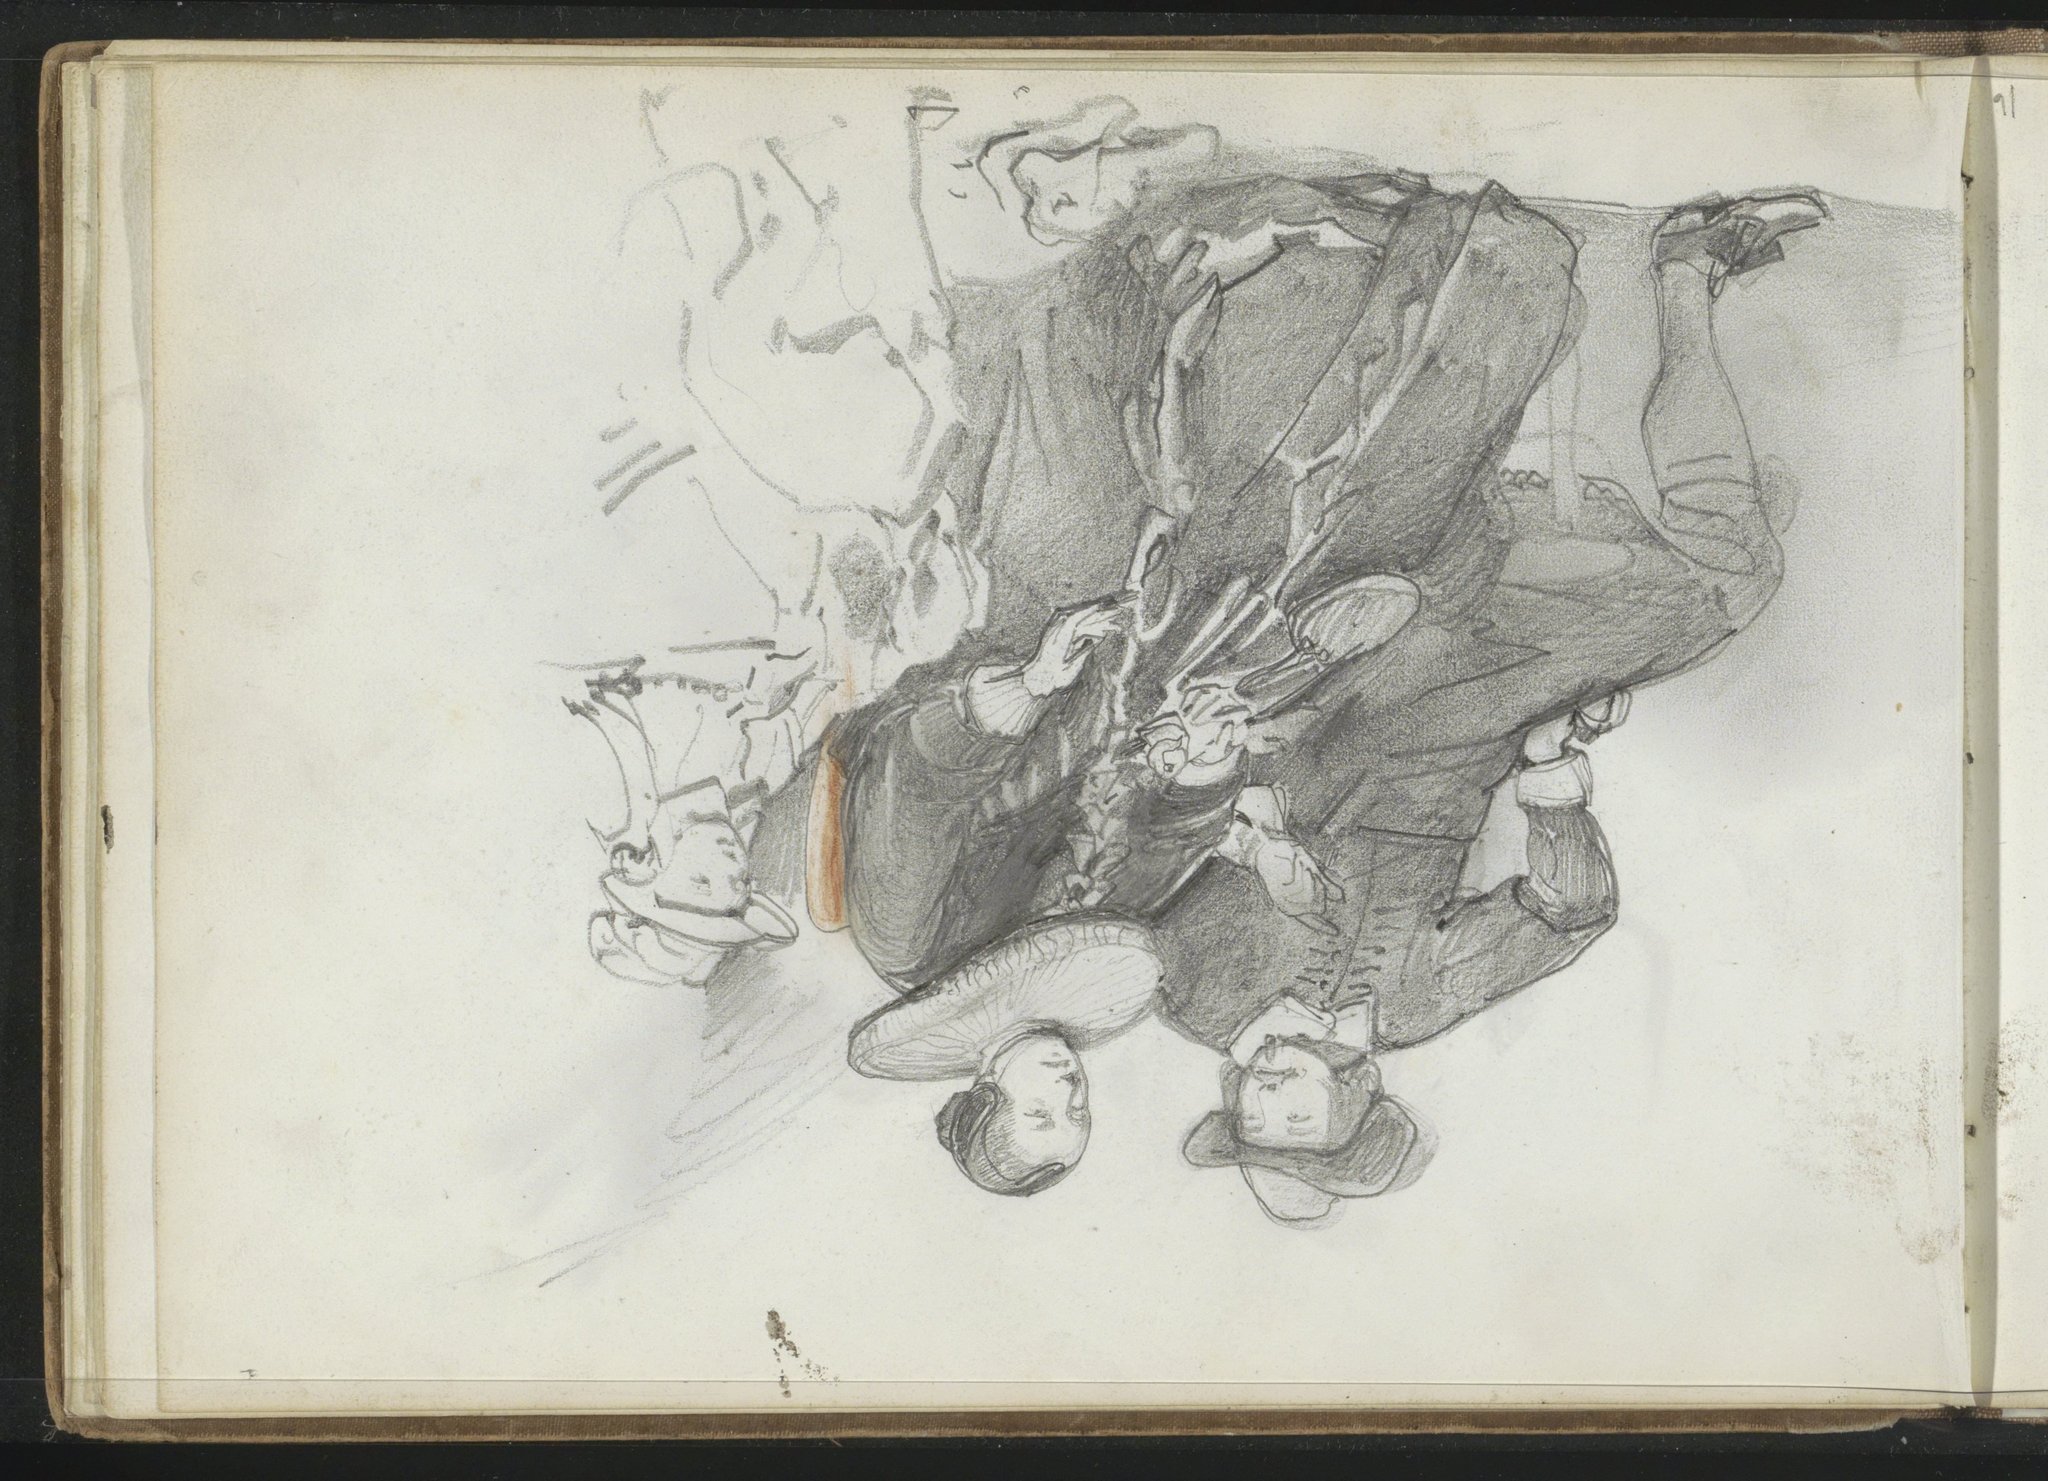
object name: sketchbook leaf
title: Portret van een echtpaar, vermoedelijk een kopie naar een zeventiende-eeuws schilderij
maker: johannes bosboom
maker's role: draughtsman, painter, print maker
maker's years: 1817-1891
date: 1827-1891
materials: chalk, paper, pencil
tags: sitting figure (+ female (human being) (not to be used where -aa- is prescribed)), sitting figure (+ male human being (not to be used where -a- is prescribed)), historical costume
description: Blad 17 verso uit een schetsboek met 41 pagina's.